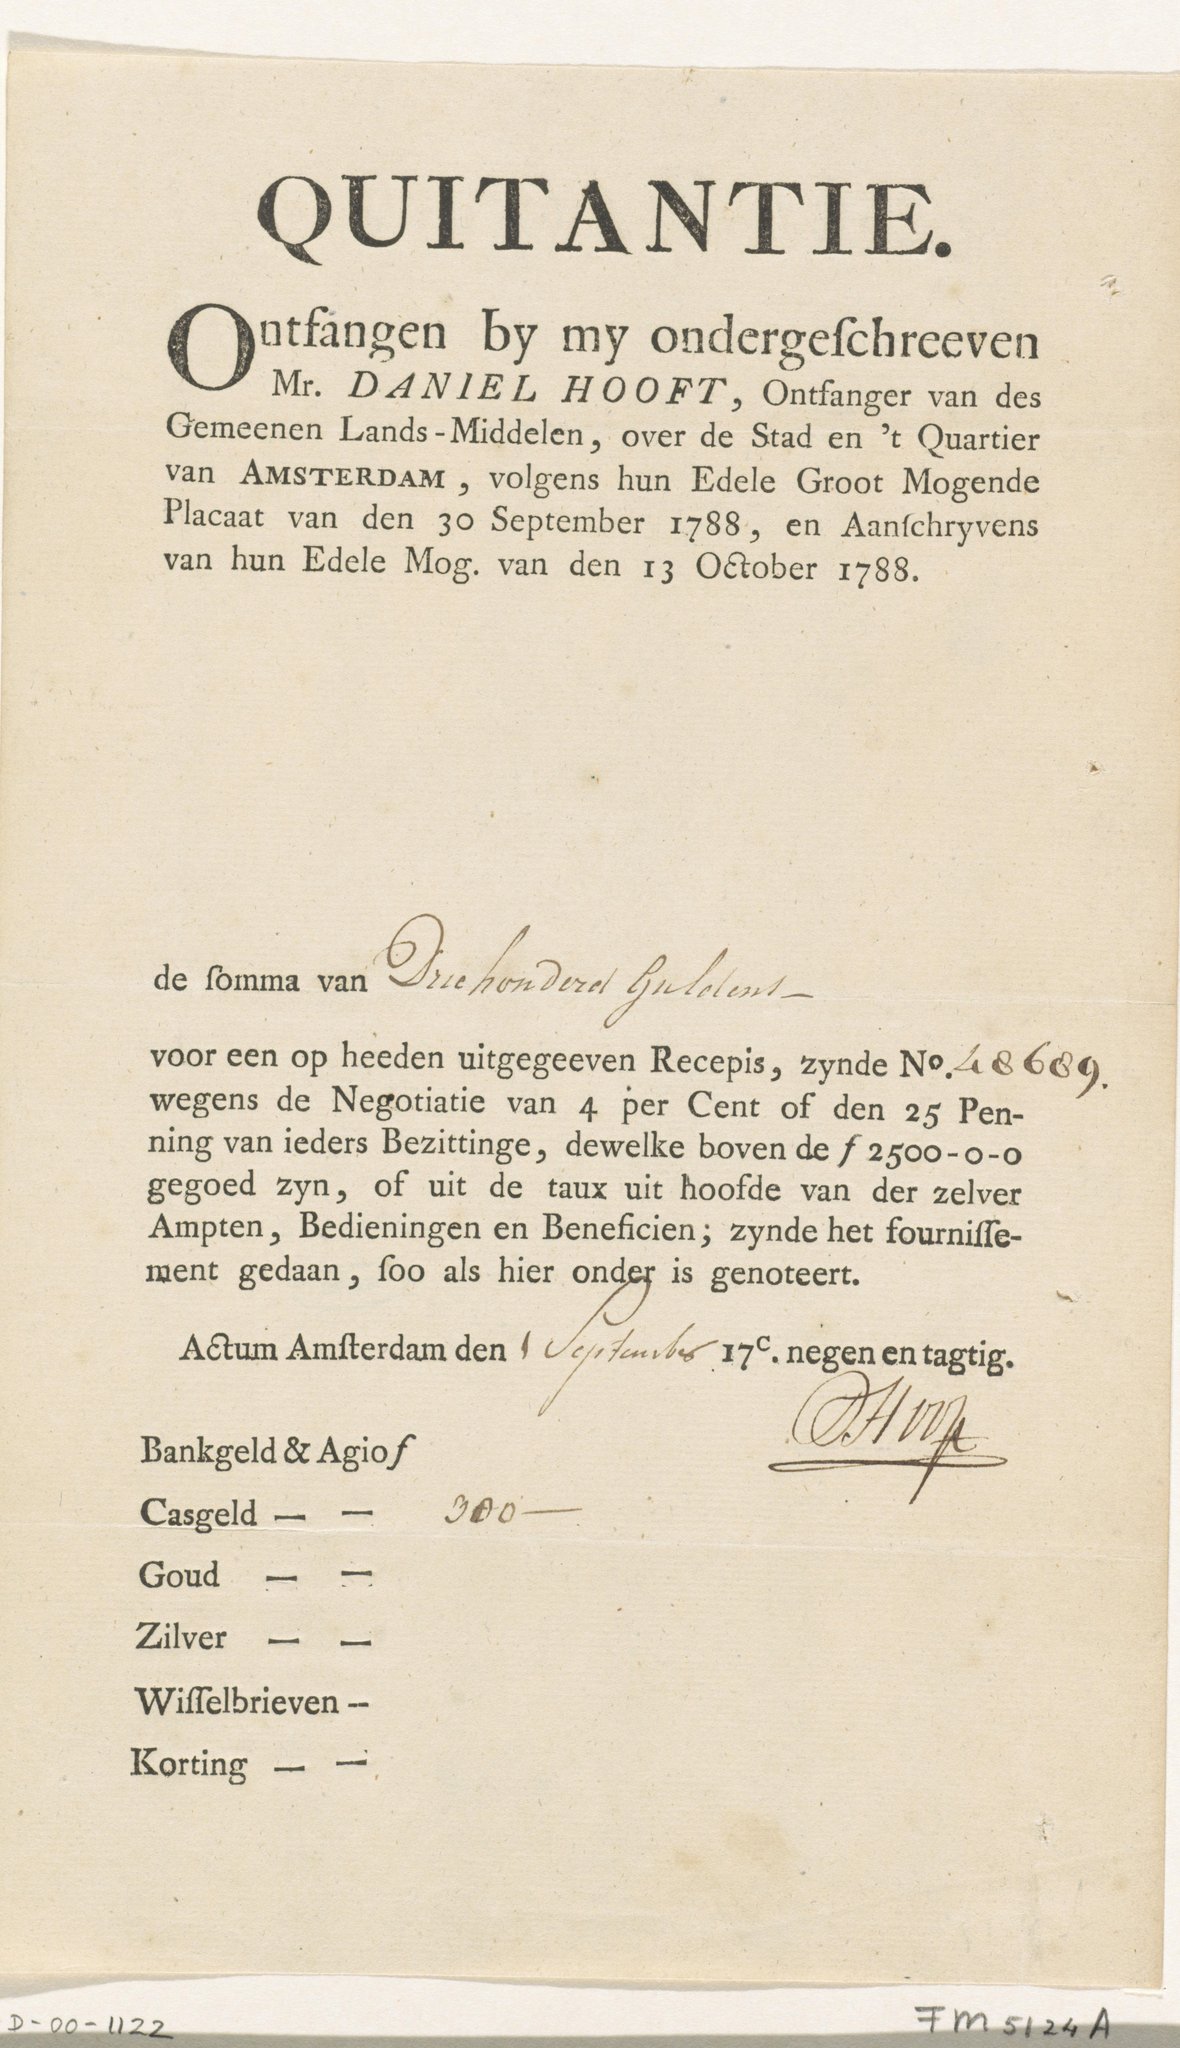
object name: ontvangstbewijs, kwitantie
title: Kwitantie op naam van Daniel Hooft, 1789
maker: Anonymous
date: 1789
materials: paper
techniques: letterpress printing, writing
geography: northern netherlands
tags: daniël hooft, amsterdam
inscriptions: collector's mark: Lugt 2228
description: Kwitantie uitgeschreven door Daniël Hooft als ontvanger van de gemeene landsmiddelen op 1 september 1789. Voorgedrukt blad waarop met pen de bedragen zijn ingevuld, ondertekend door Hooft.